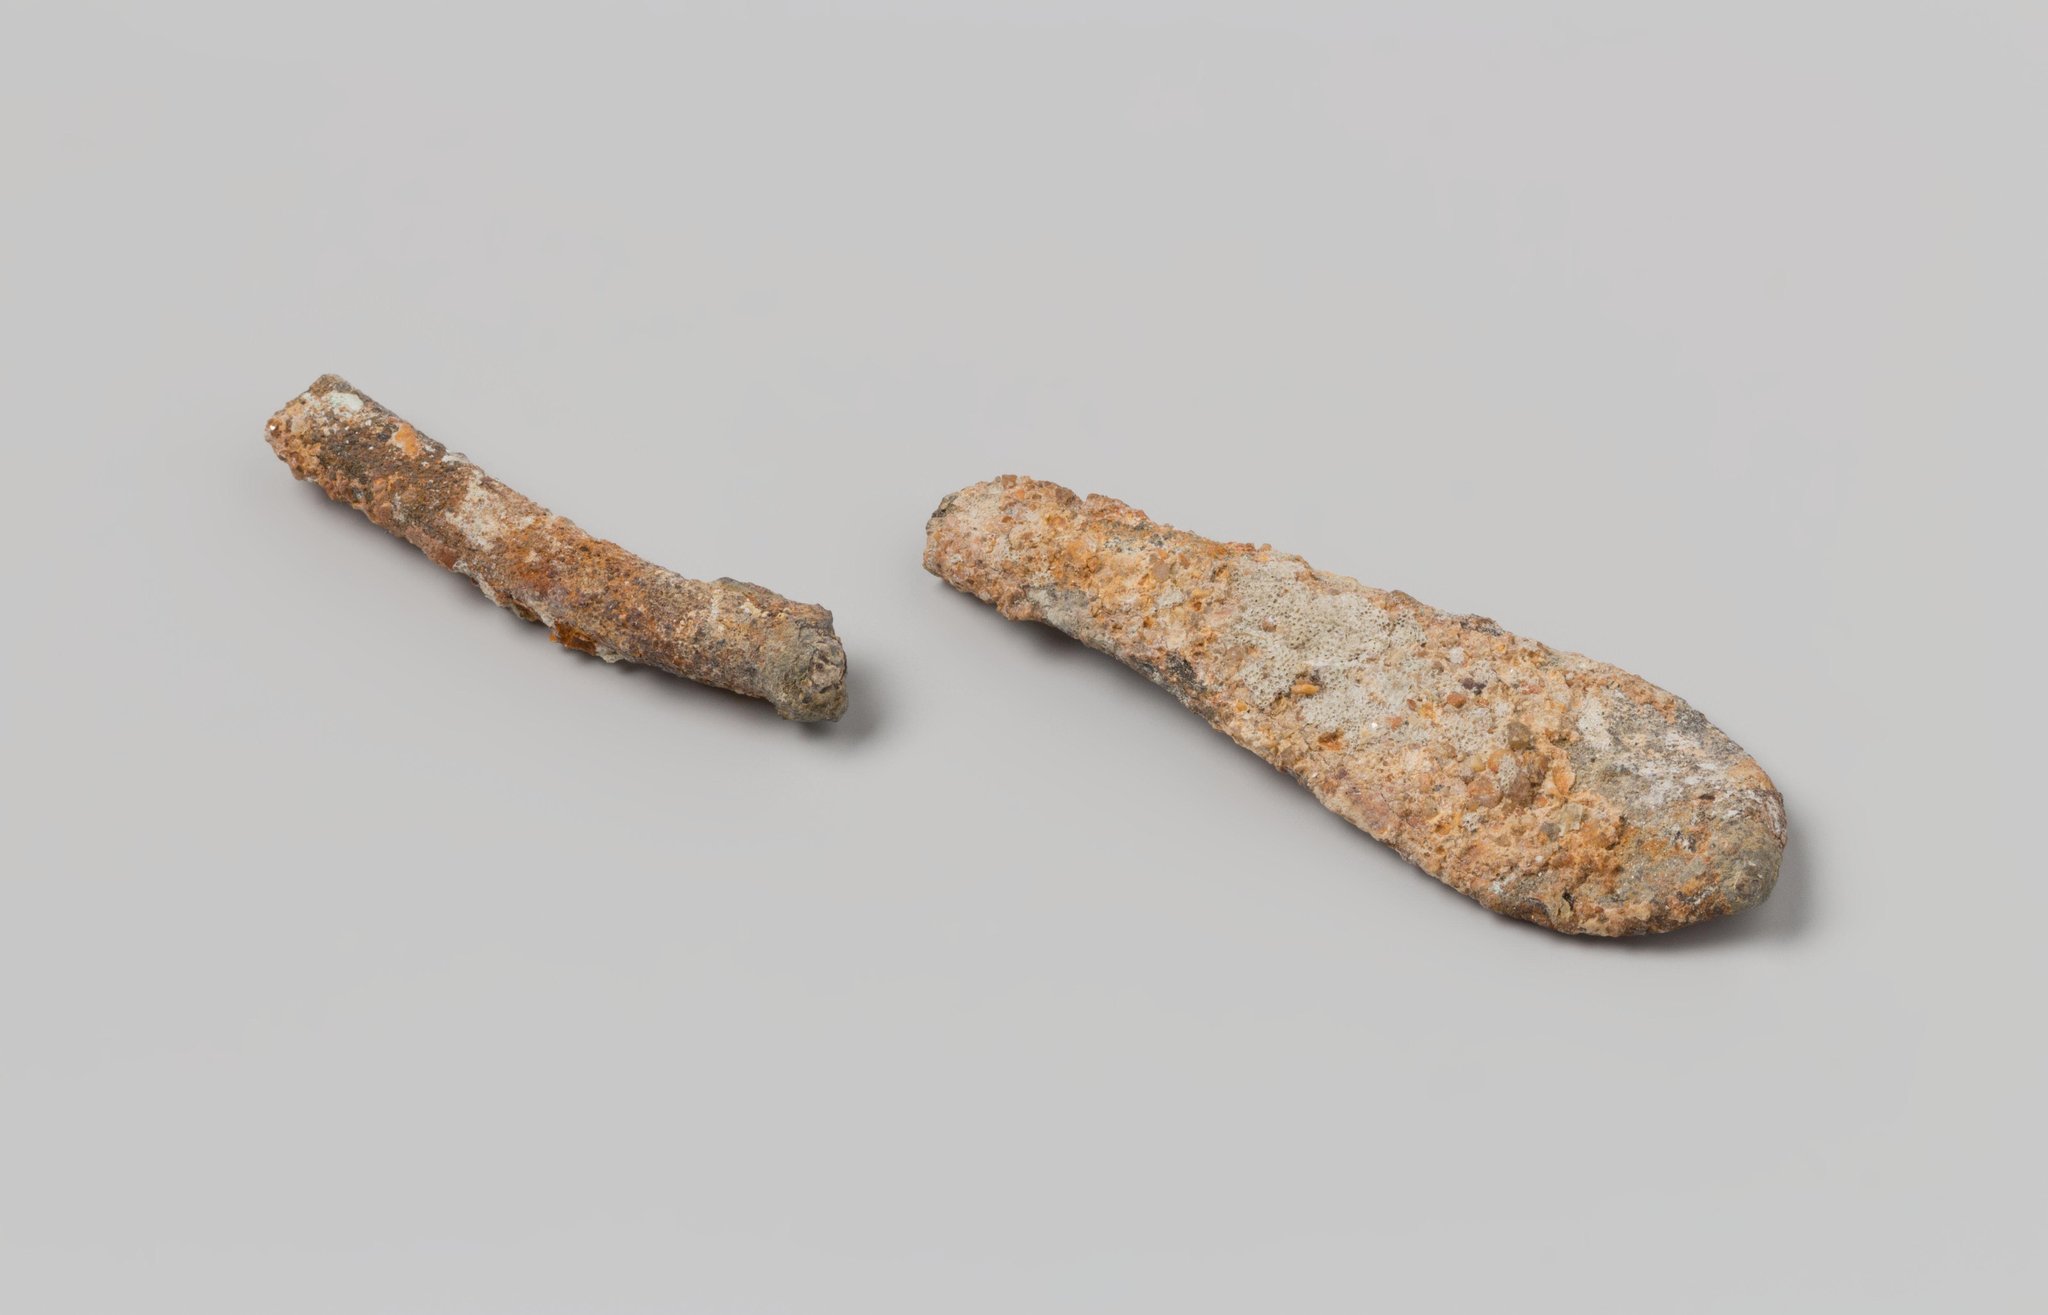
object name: spoon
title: Fragmenten steel van vork of lepel uit het wrak van de Oost-Indiëvaarder Hollandia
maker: Anonymous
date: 1700-1743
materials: tin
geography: netherlands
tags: verenigde oostindische compagnie, hollandia (schip), annet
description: Cutlery, fragment: stem of fork or spoon; fragm, encrusted, sim. NG 1980-27H67.